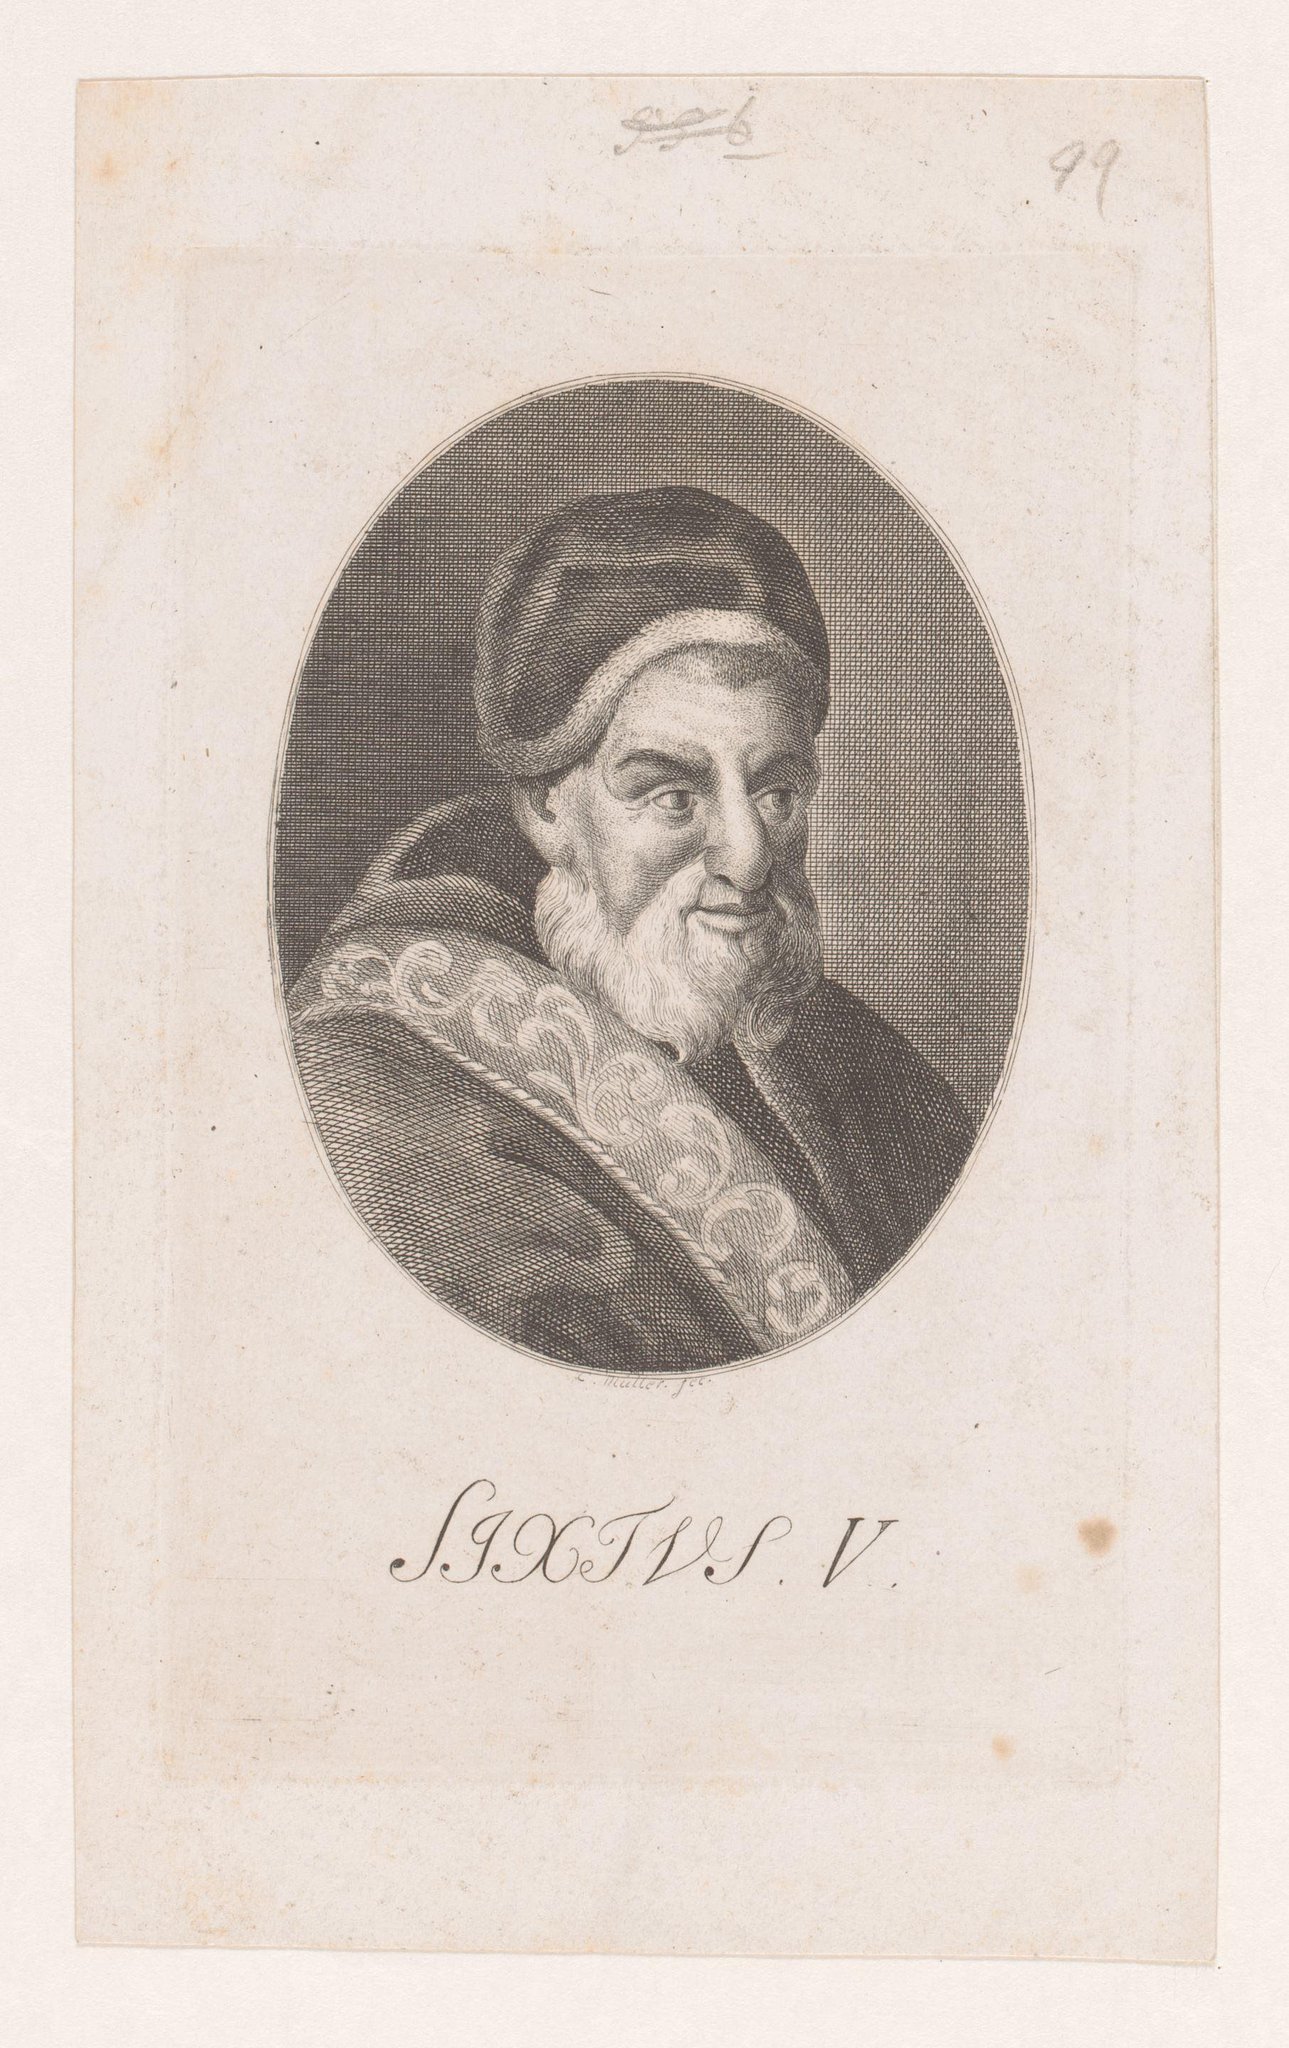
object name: print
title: Portret van Sixtus V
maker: johann christian ernst müller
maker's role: draughtsman, print maker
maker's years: 1766-1824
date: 1776-1824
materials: paper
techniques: etching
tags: sixtus v, historical persons, pope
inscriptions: collector's mark: Lugt 2228